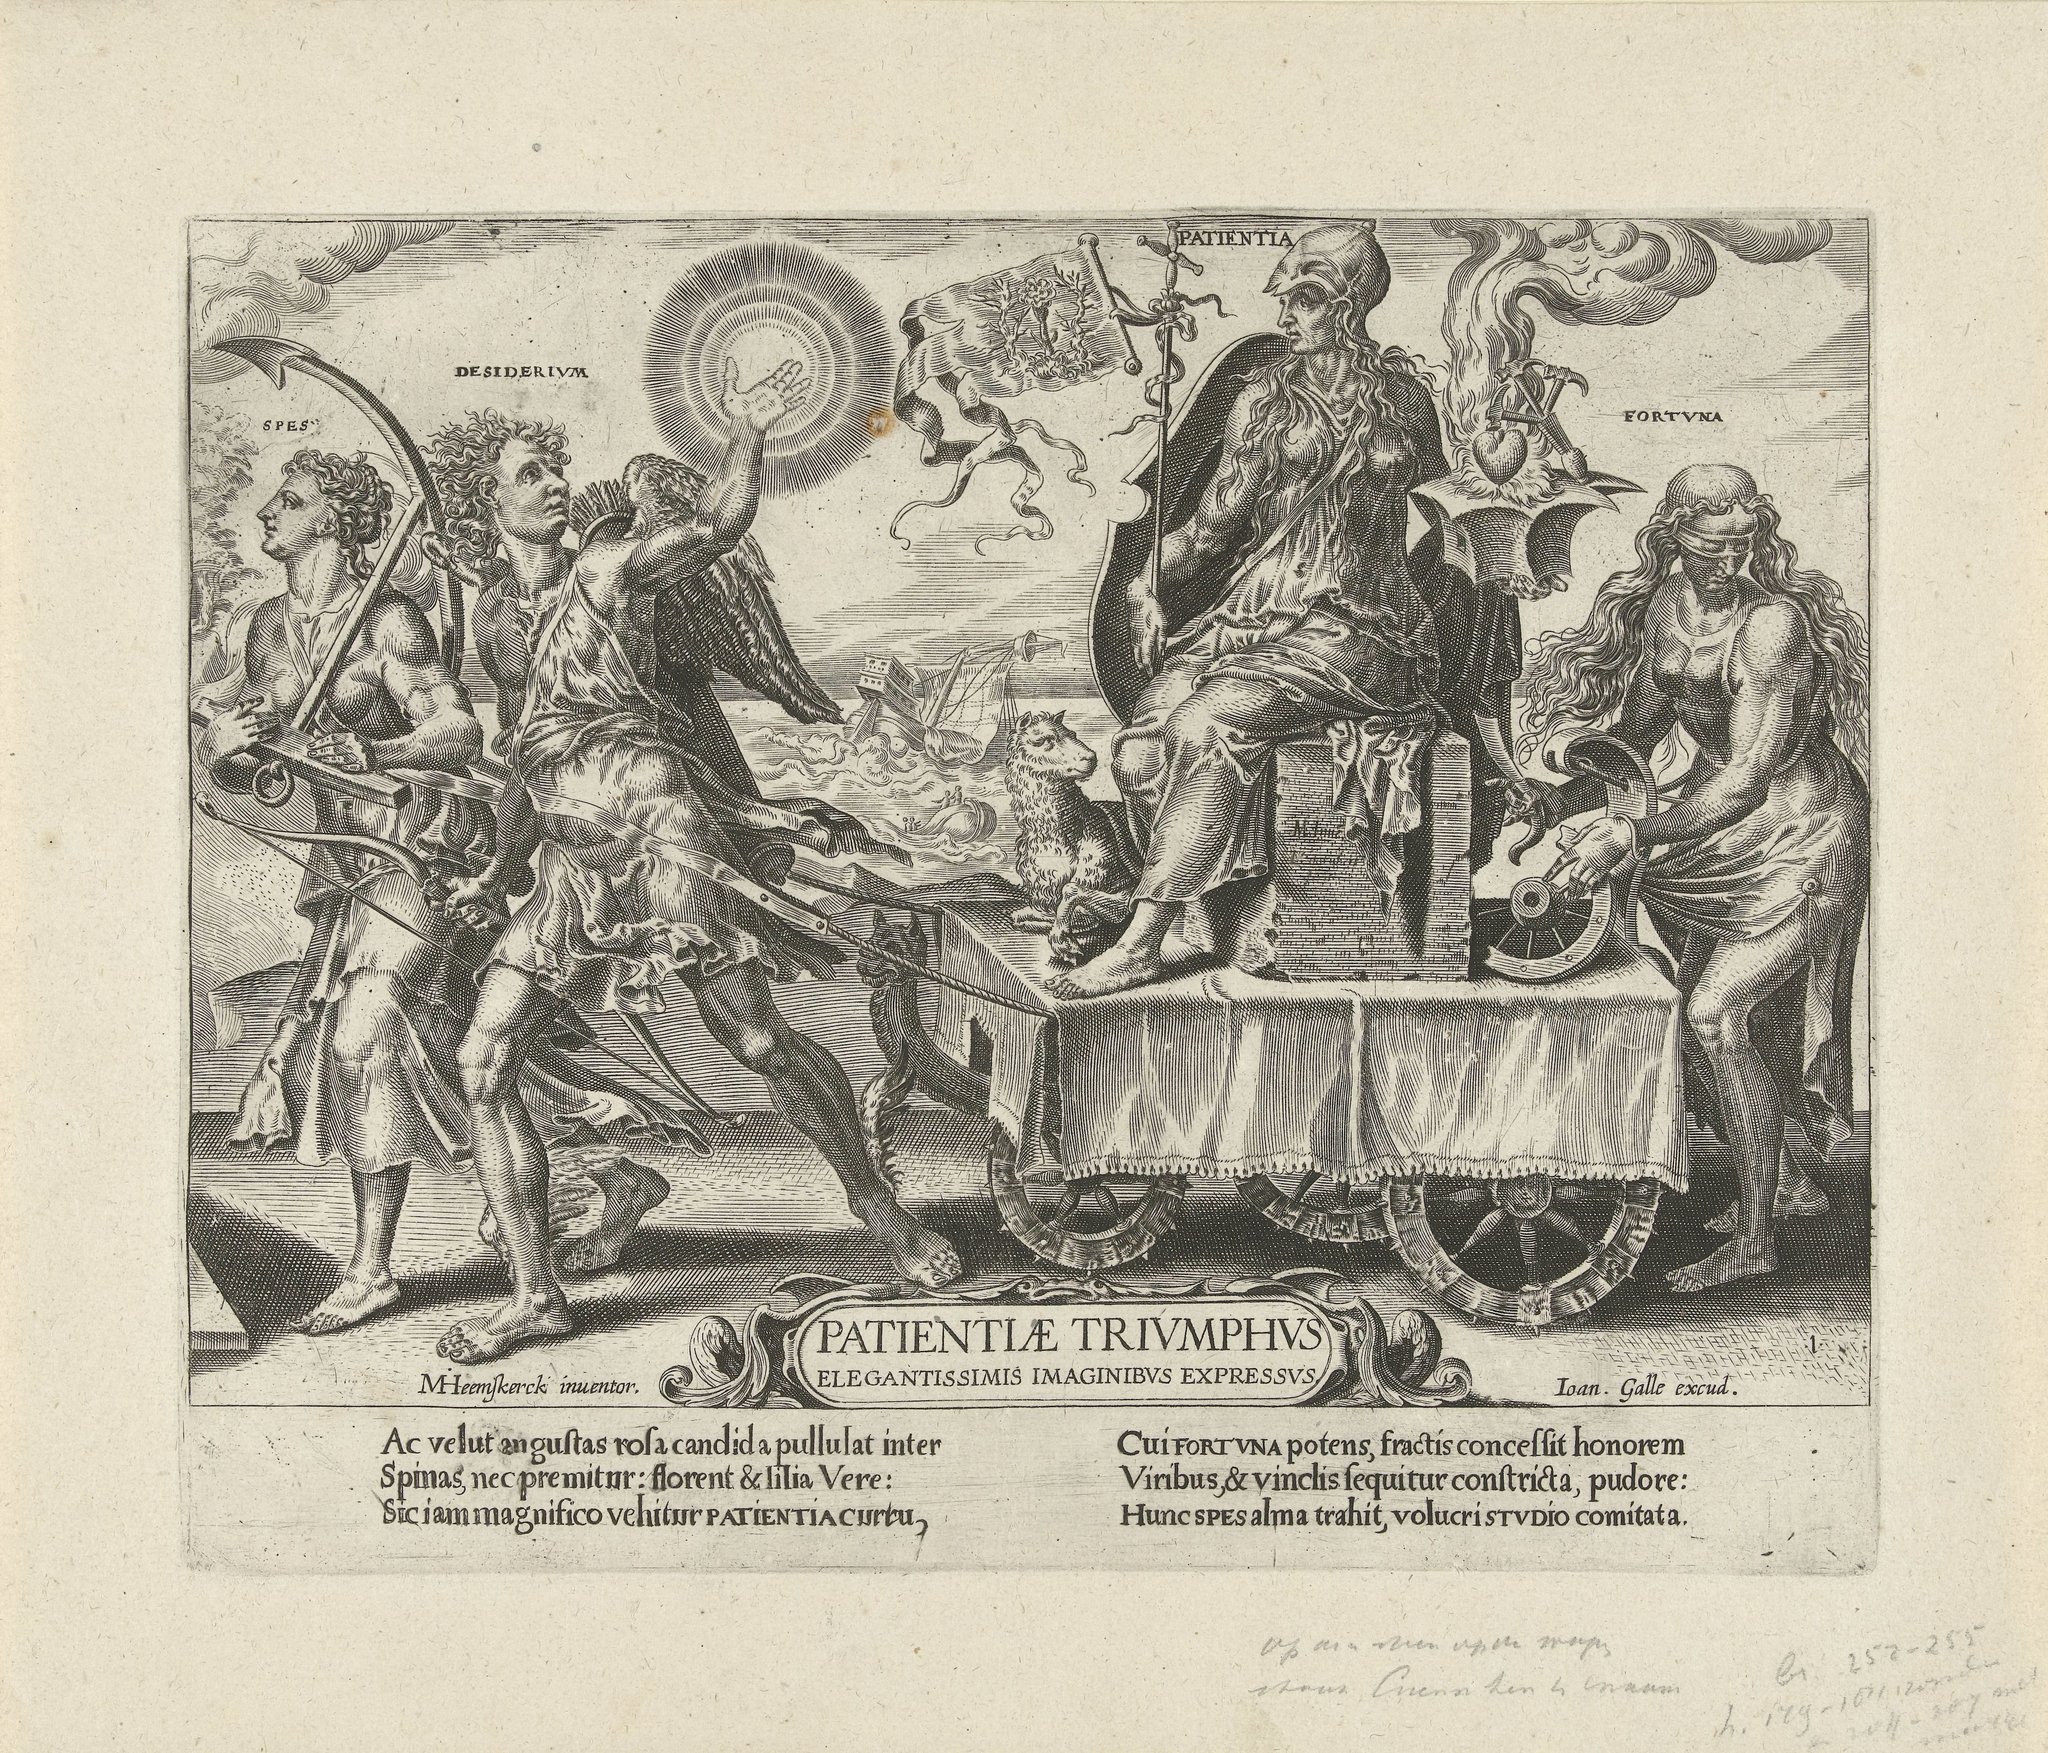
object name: print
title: Triomf van de lijdzaamheid (Patientia)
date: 1559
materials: paper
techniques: engraving, etching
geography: haarlem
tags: hope, 'spes'; 'speranza divina e certa' (ripa) ~ one of the three theological virtues, triumphs (allegorical and symbolic), heart, luck, fortune, lot; 'fato', 'fortuna', 'fortuna aurea', 'fortuna buona', 'fortuna pacifica overo clemente', 'sorte' (ripa), storm at sea, desire; 'desiderio' (ripa), patience; 'patienza' (ripa) (+ allegorical scene, i.e. two or more personifications involved in an action)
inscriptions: inscription: ‘H.C.G.V.S. Const. 12 Gger’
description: Op de voorgrond de triomfwagen van Lijdzaamheid (Patientia), getrokken door Hoop (Spes) en Verlangen (Desiderium). Patientia zit op een vierkanten steen op de wagen. In haar linkerhand een brandend hart op een aambeeld dat door drie hamers gebeukt wordt. In haar rechterhand een vaandel met een roos tussen doornen. Naast haar zit het lam als teken van lijdzaamheid. Achter de triomfwagen wordt de geketende Fortuna meegevoerd. Ze draagt als attributen het scheermes (scherpte) en het gebroken rad (haar krachten zijn gebroken). In de achtergrond een schip in een storm. De prent heeft op een afzonderlijk stuk papier een Latijnse tekst van zes regels en maakt deel uit van een achtdelige serie over de triomf van de Lijdzaamheid.